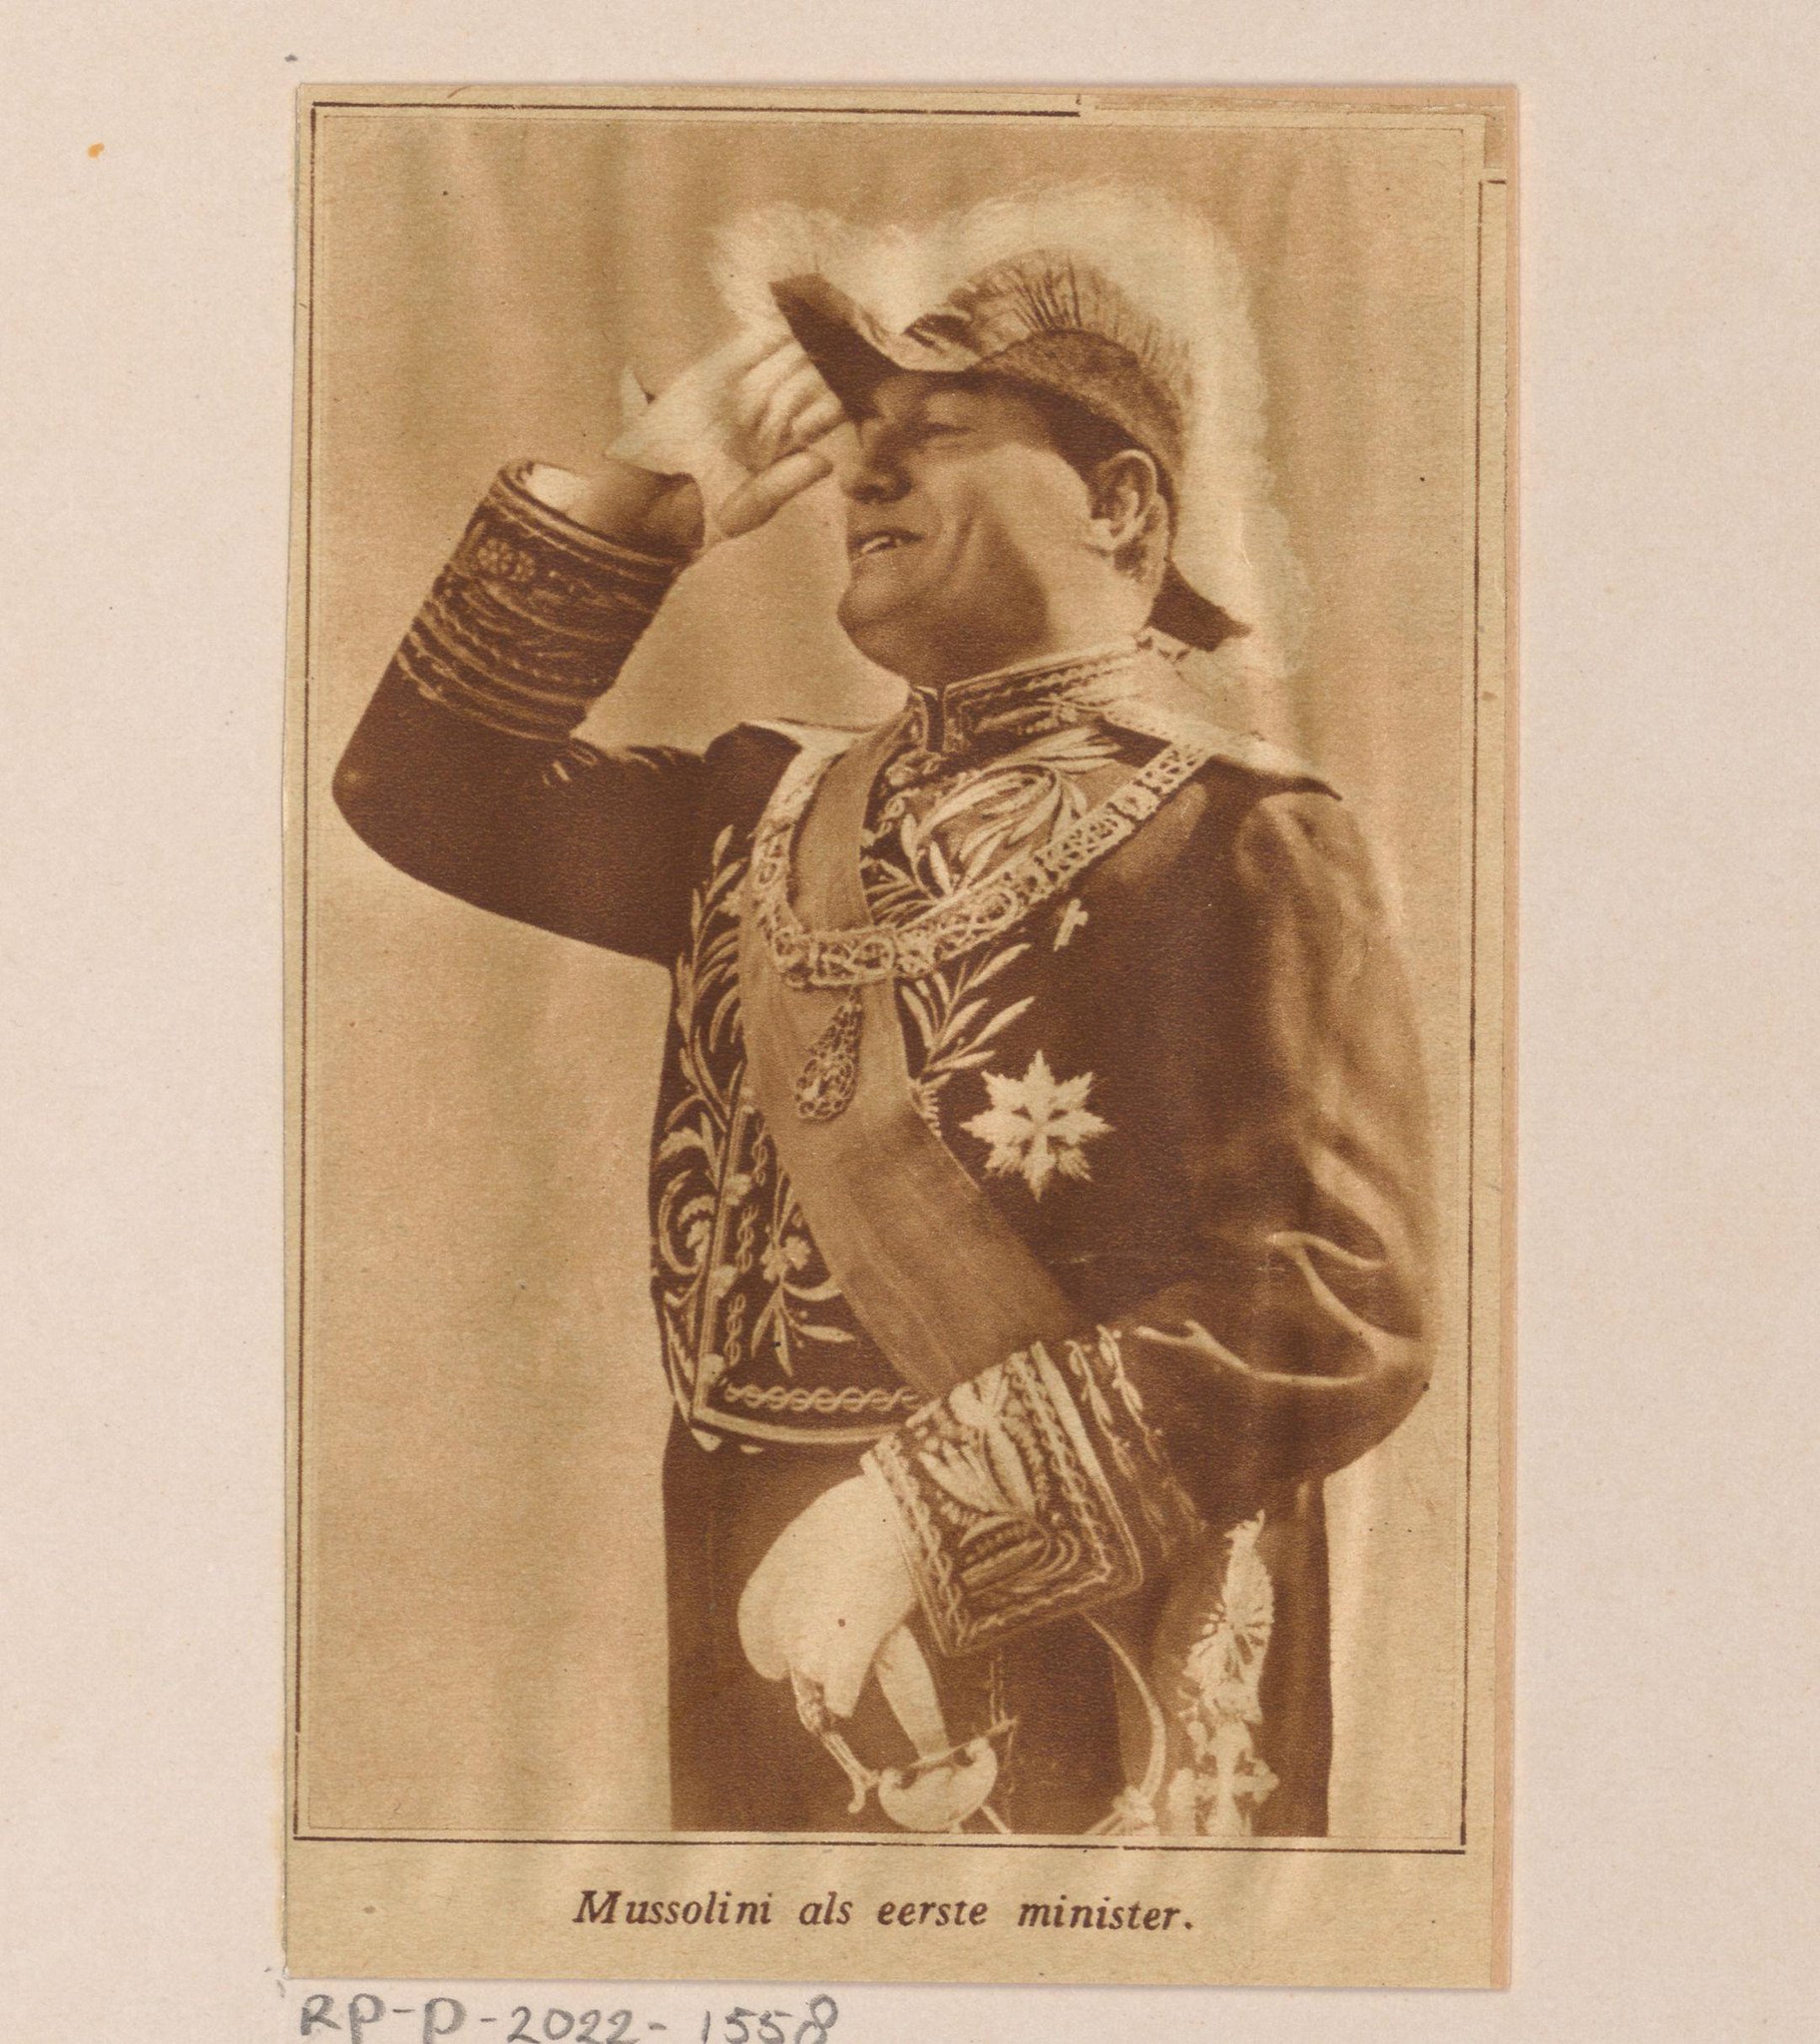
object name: photomechanical print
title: Portret van Benito Mussolini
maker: Anonymous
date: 1922-1930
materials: paper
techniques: photograph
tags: politician, historical persons, politician, e.g. party leader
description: Met eenregelig onderschrift in het Nederlands.